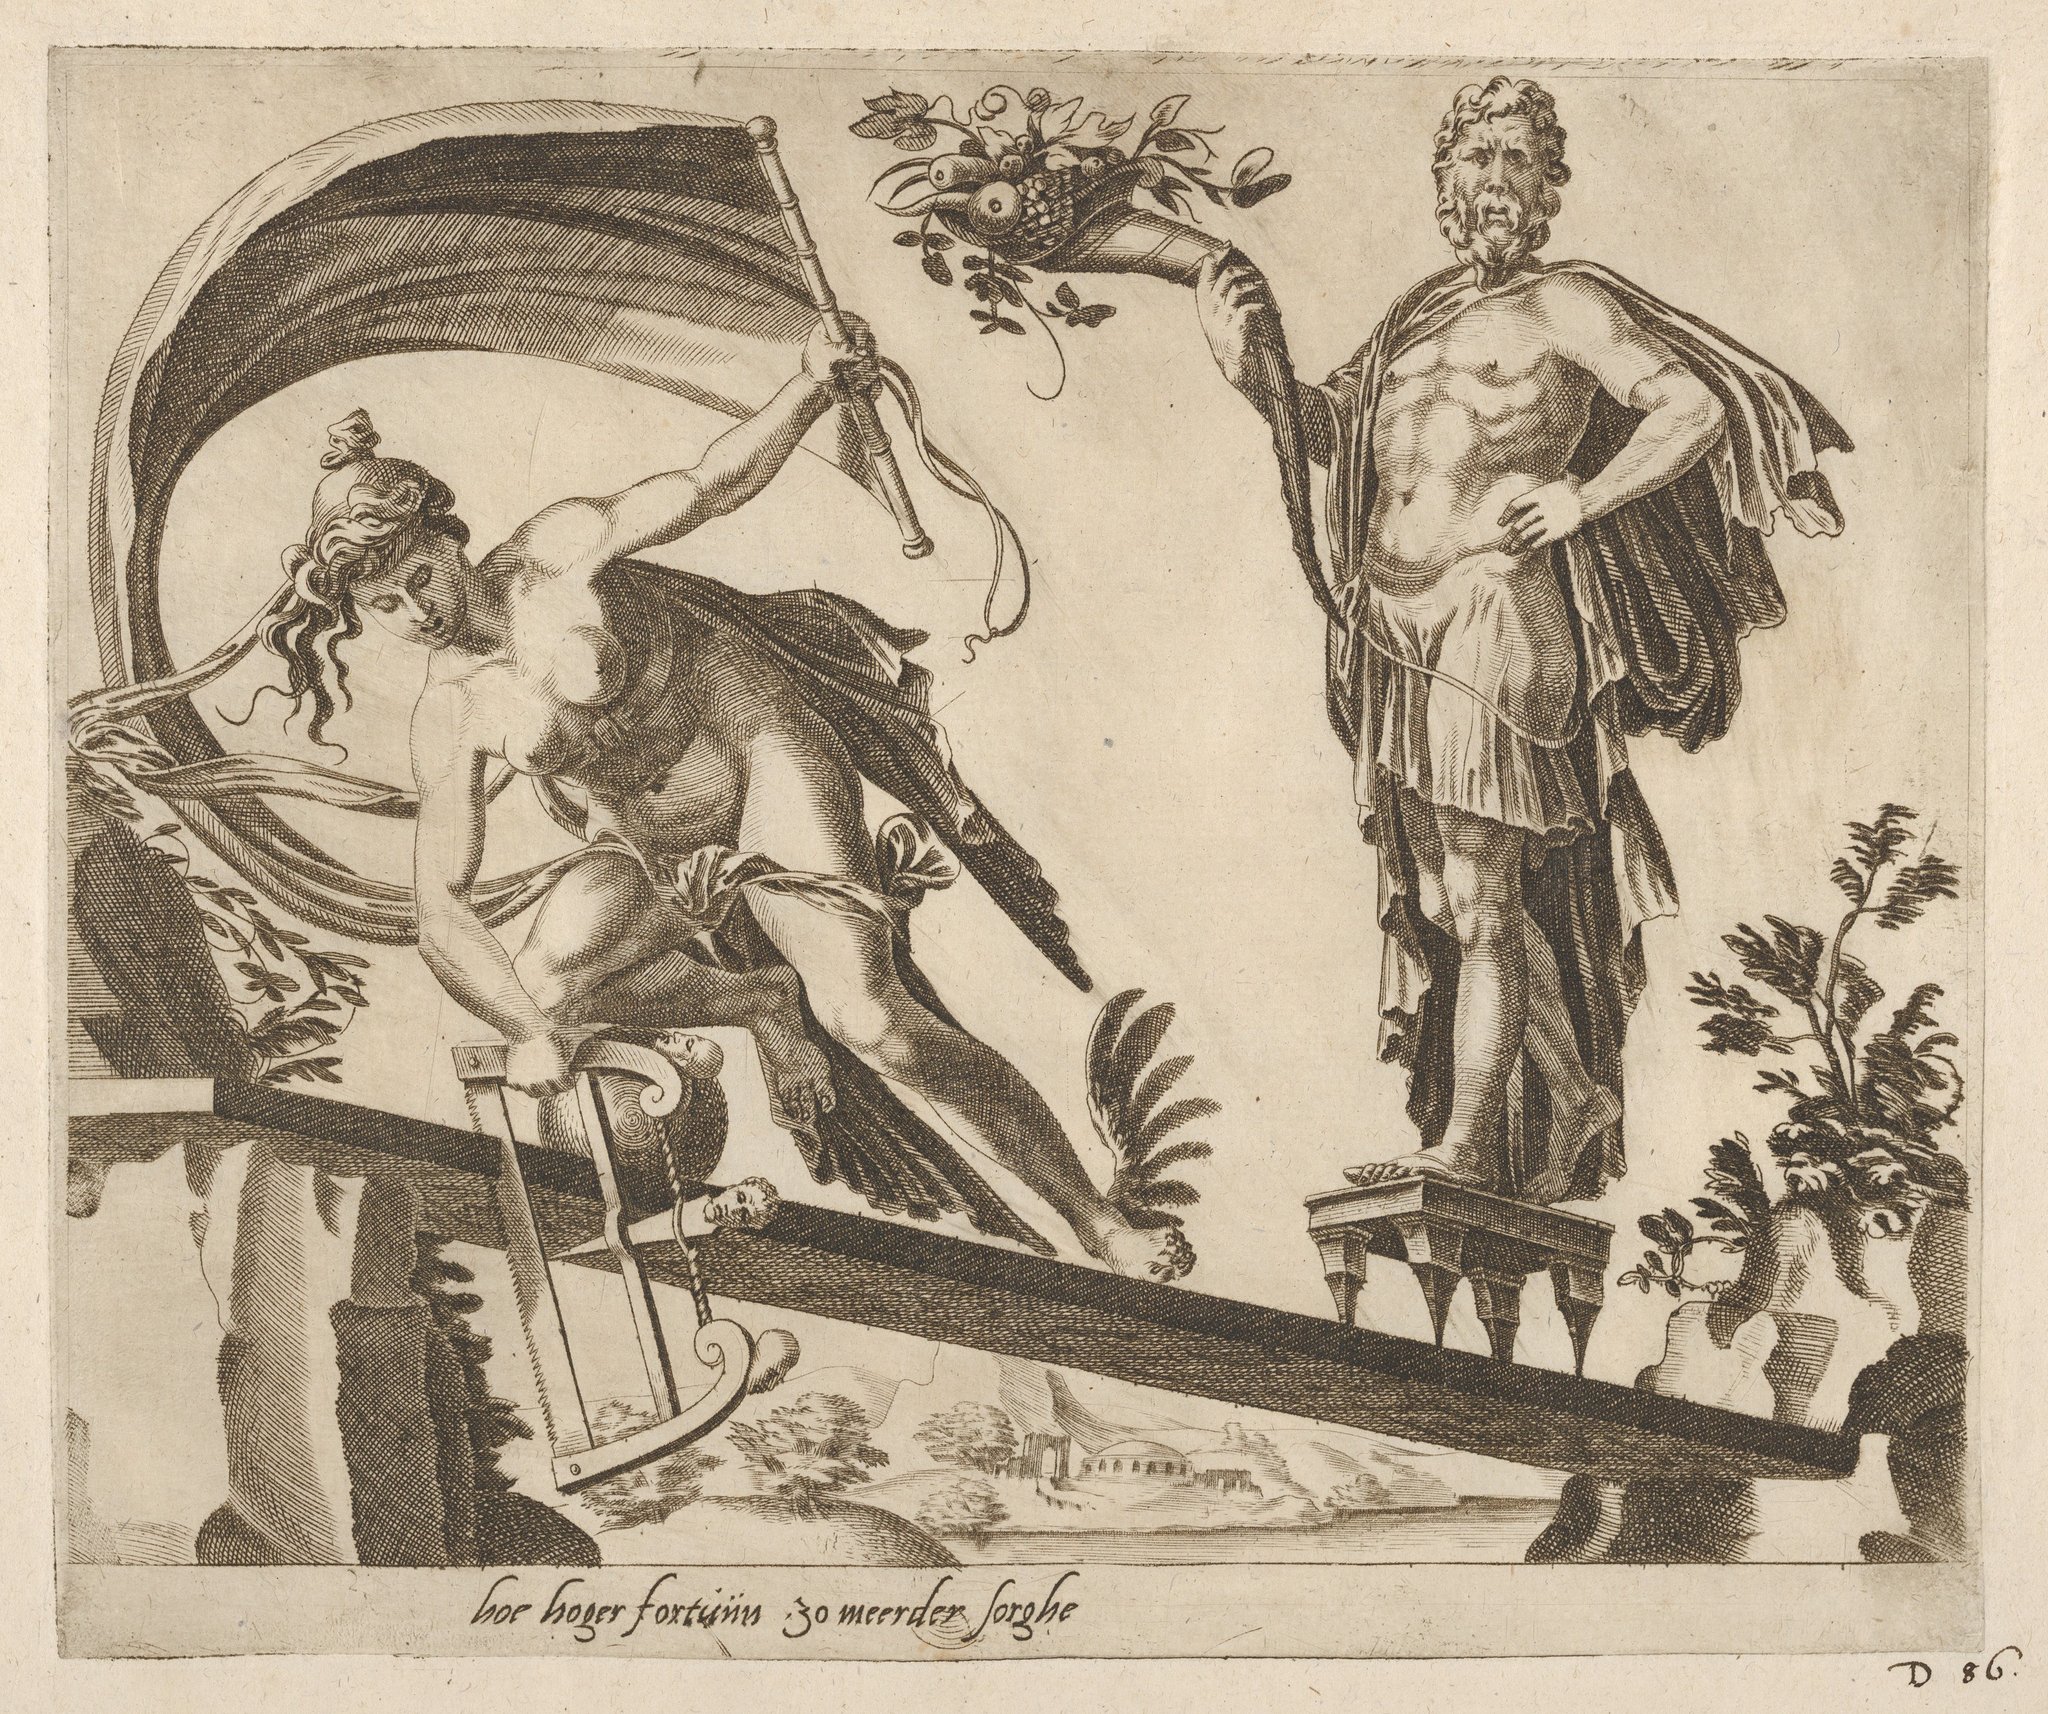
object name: print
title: When Fortune Is Abundant, the Fall Will Be Deeper from Six Sayings about Fortune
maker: dirck volckertsz coornhert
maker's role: artist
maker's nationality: netherlandish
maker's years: 1519-1590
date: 1560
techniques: engraving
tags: men,female nudes,cornucopia